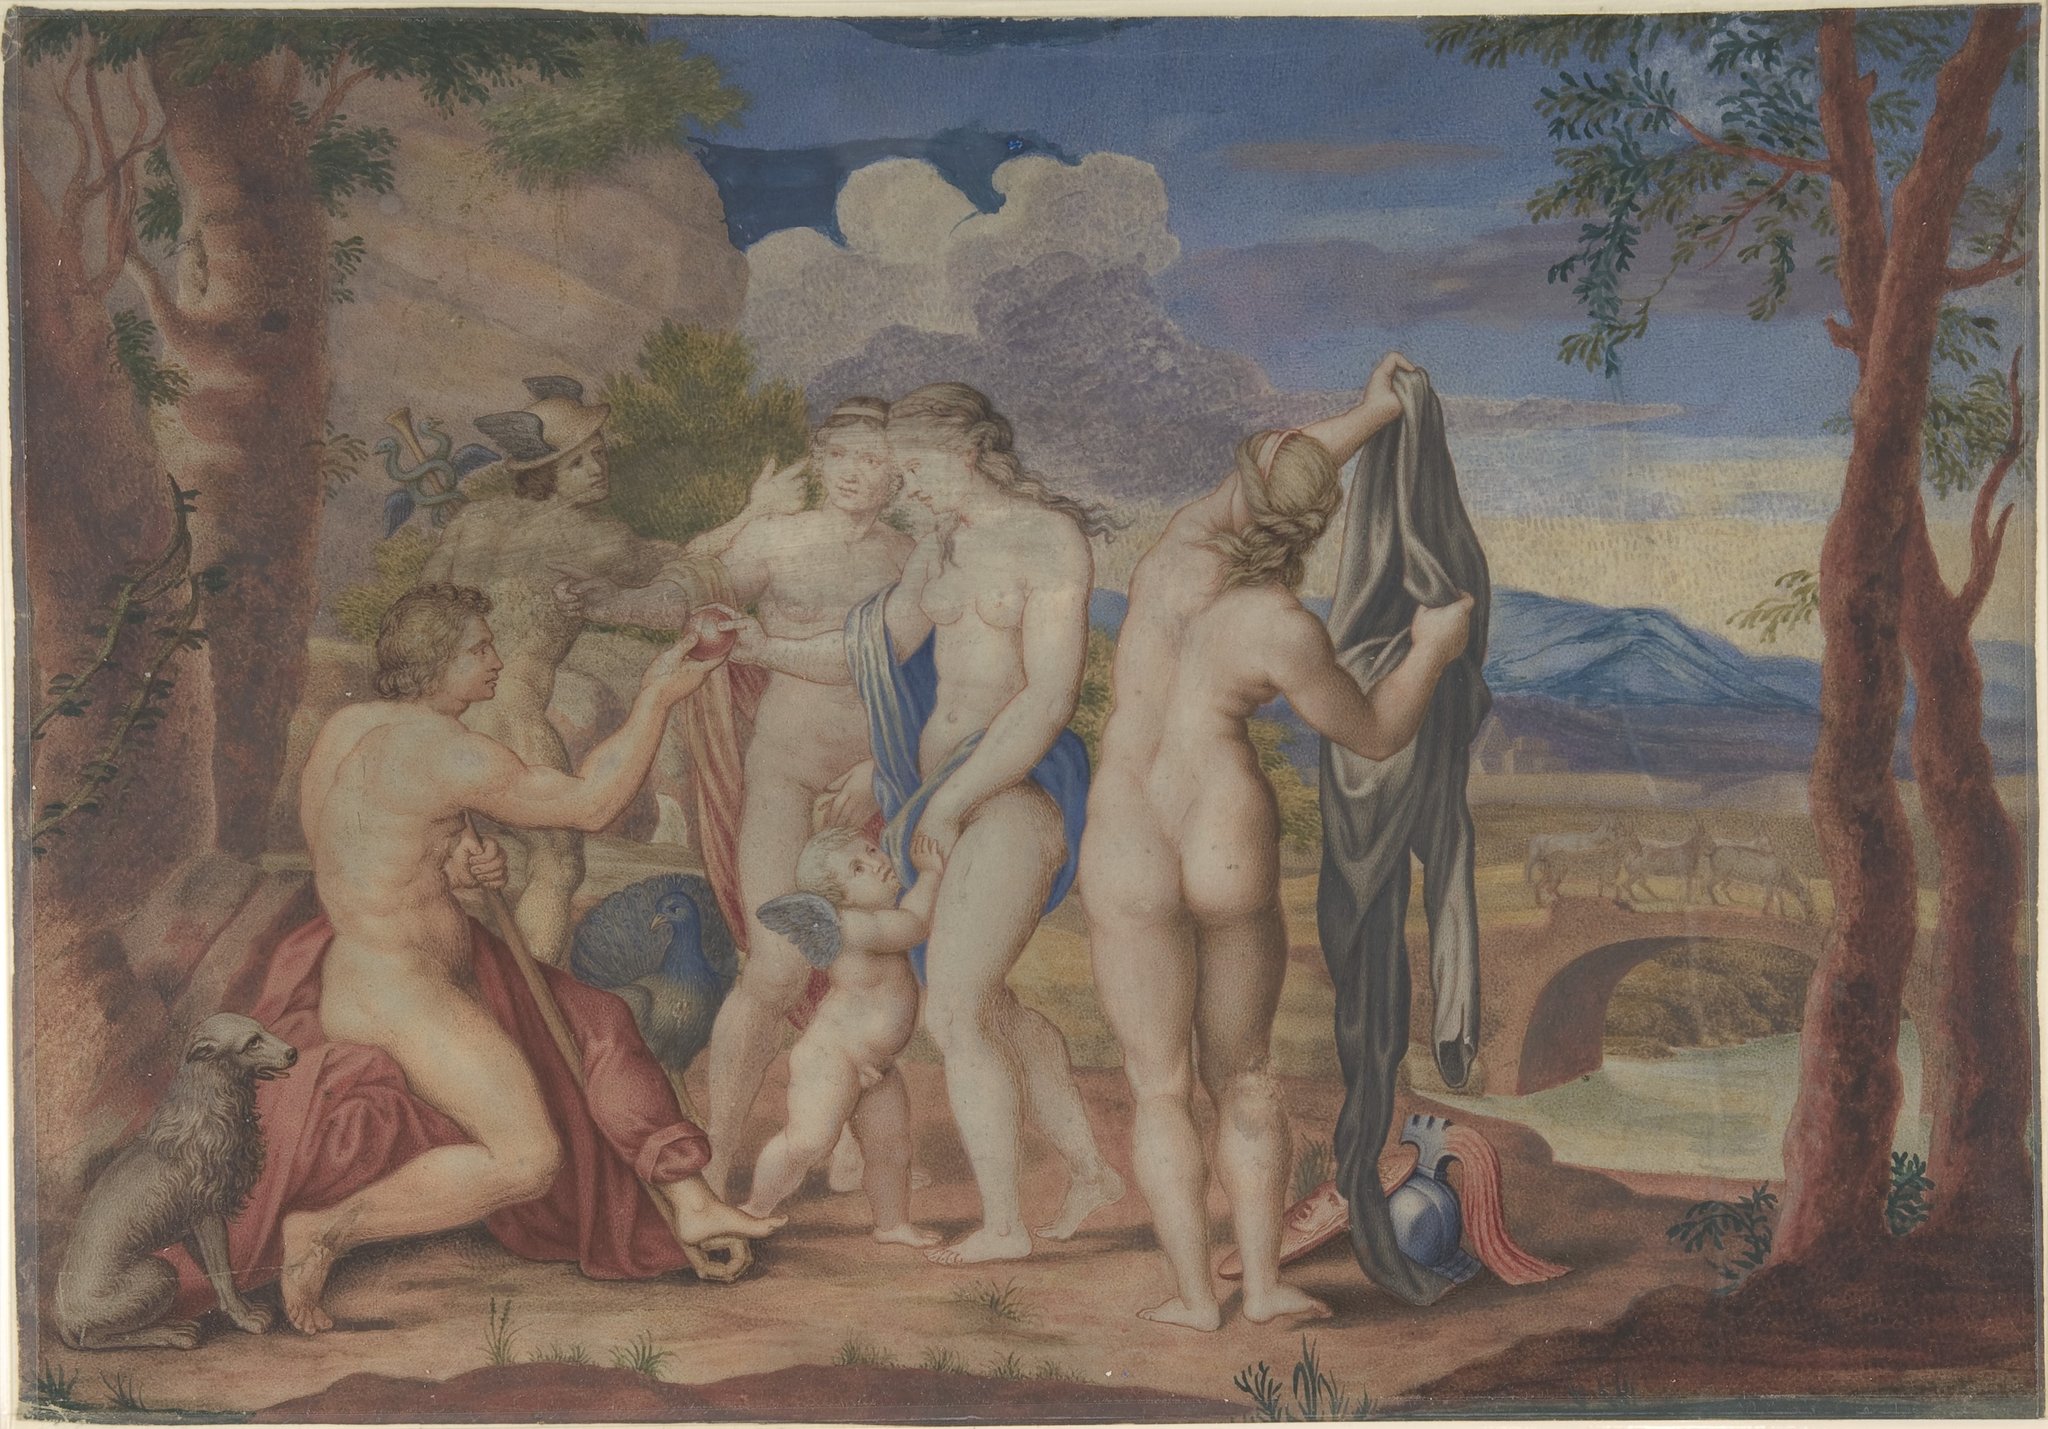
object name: drawing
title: Judgment of Paris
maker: anonymous, italian, 19th century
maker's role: artist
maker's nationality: italian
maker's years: 1800-1900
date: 1800-1900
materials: gouache, metal, paper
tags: male nudes,female nudes,dogs